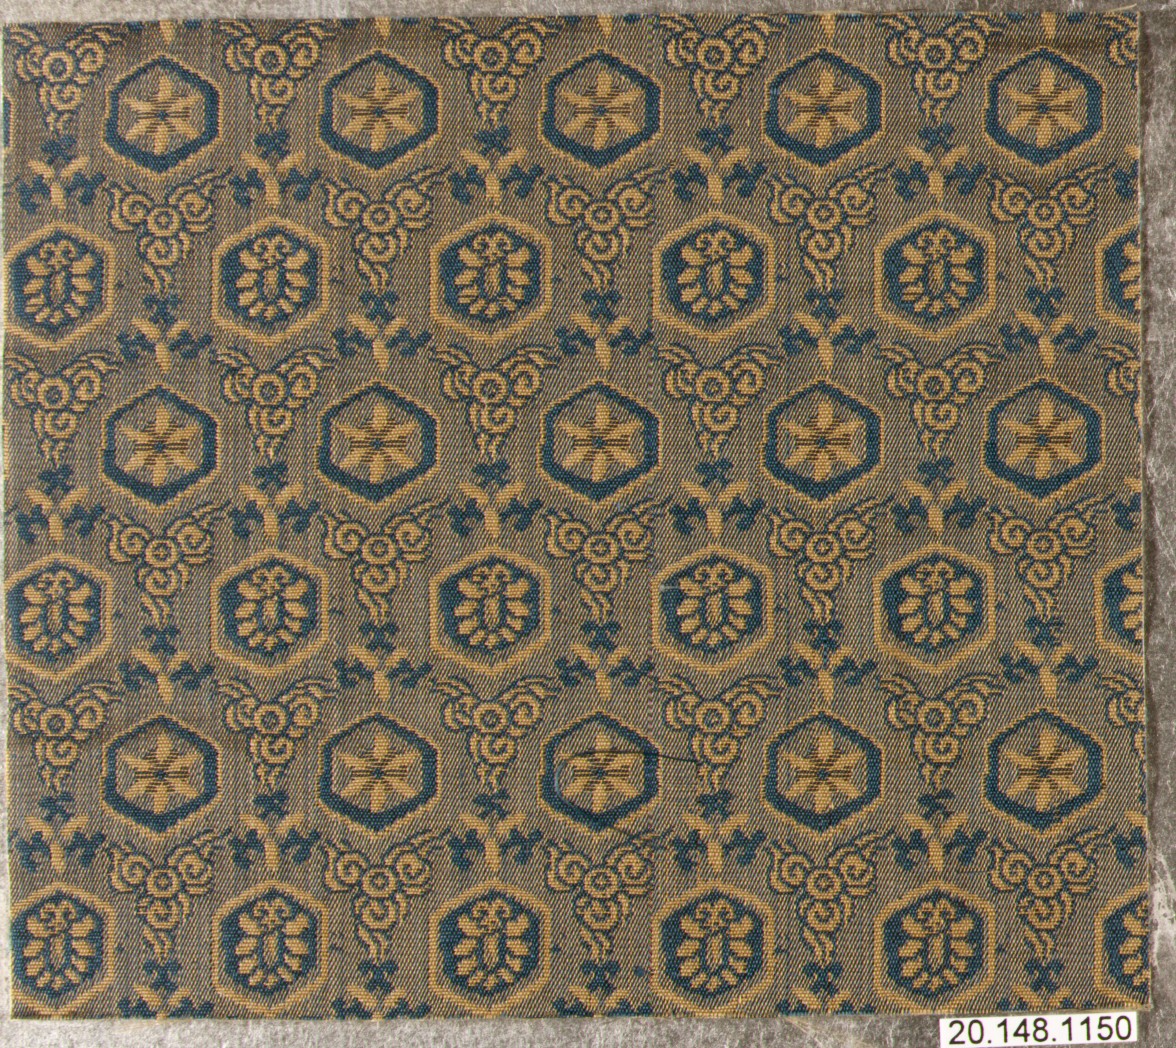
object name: piece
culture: japanese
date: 1801-1900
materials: silk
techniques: compound weave